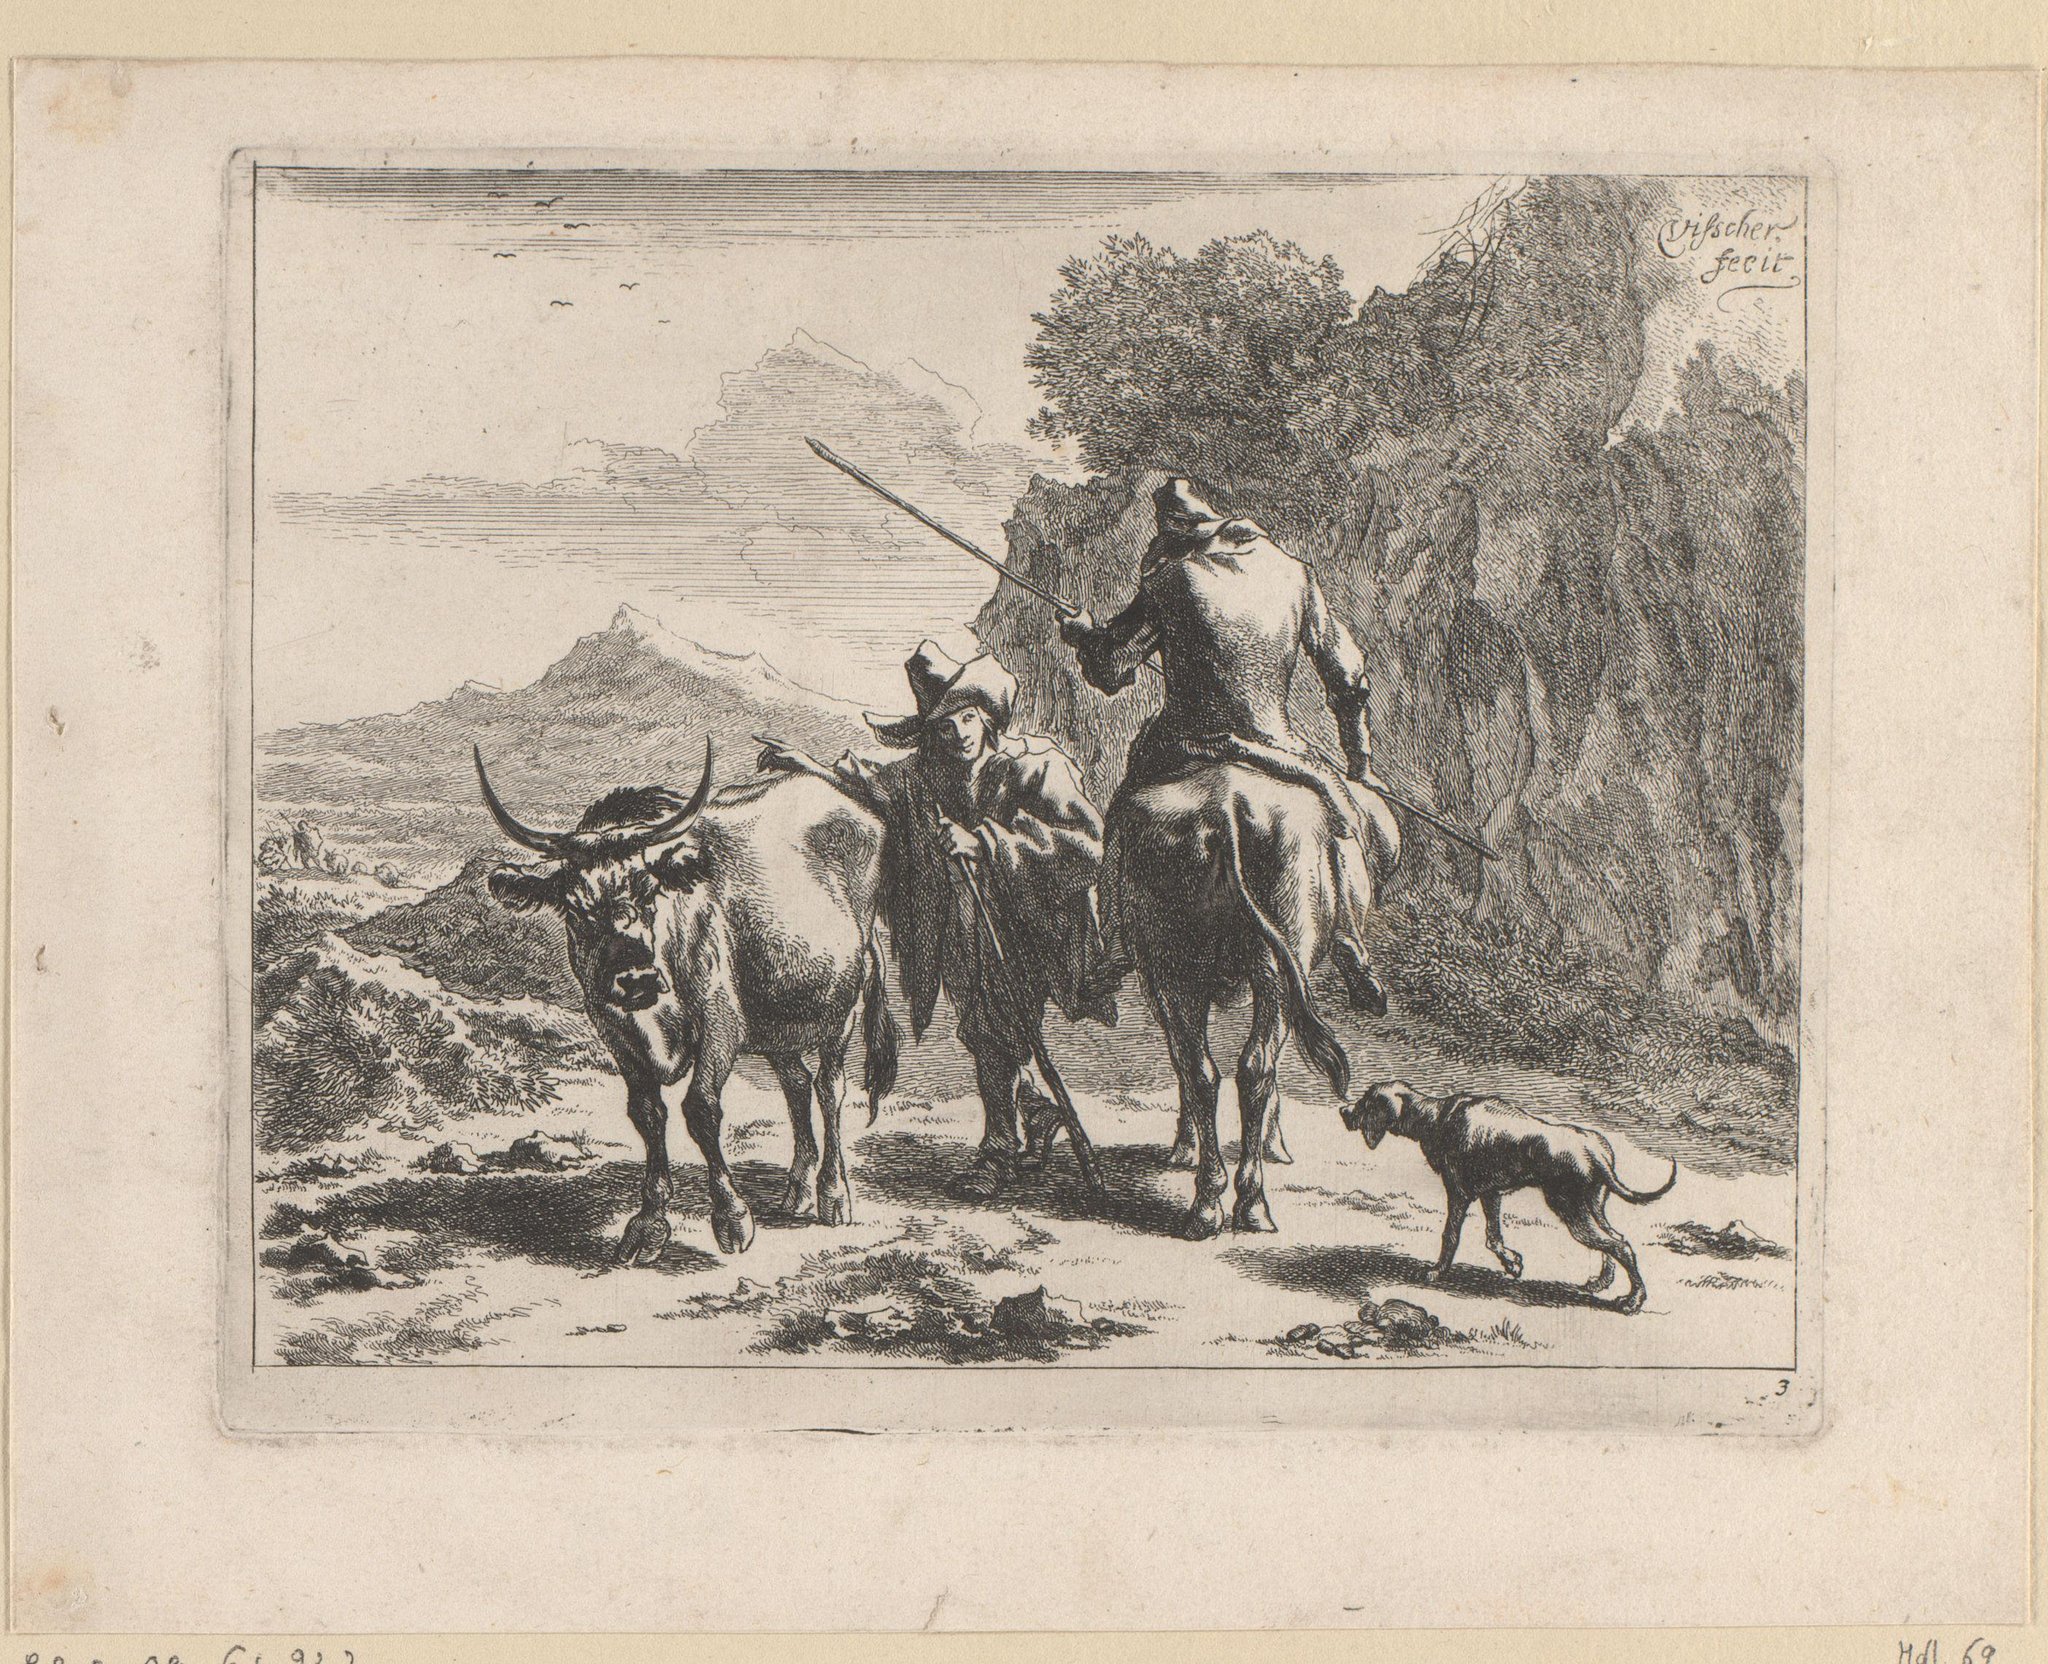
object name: print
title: Landschappen met herders en vee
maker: jan de visscher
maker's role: print maker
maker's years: 1633-1712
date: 1650-1701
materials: paper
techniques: engraving, etching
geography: northern netherlands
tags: cow, landscapes, ass, donkey, herding, herdsman, herdswoman, shepherd, shepherdess, cowherd, etc., conversation, dialogue; conversation piece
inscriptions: collector's mark: Lugt 240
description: Gezicht op een heuvelachtig landschap met twee herders die een gesprek voeren. Een van de herders zit op zijn ezel, terwijl de andere naast zijn koe loopt.